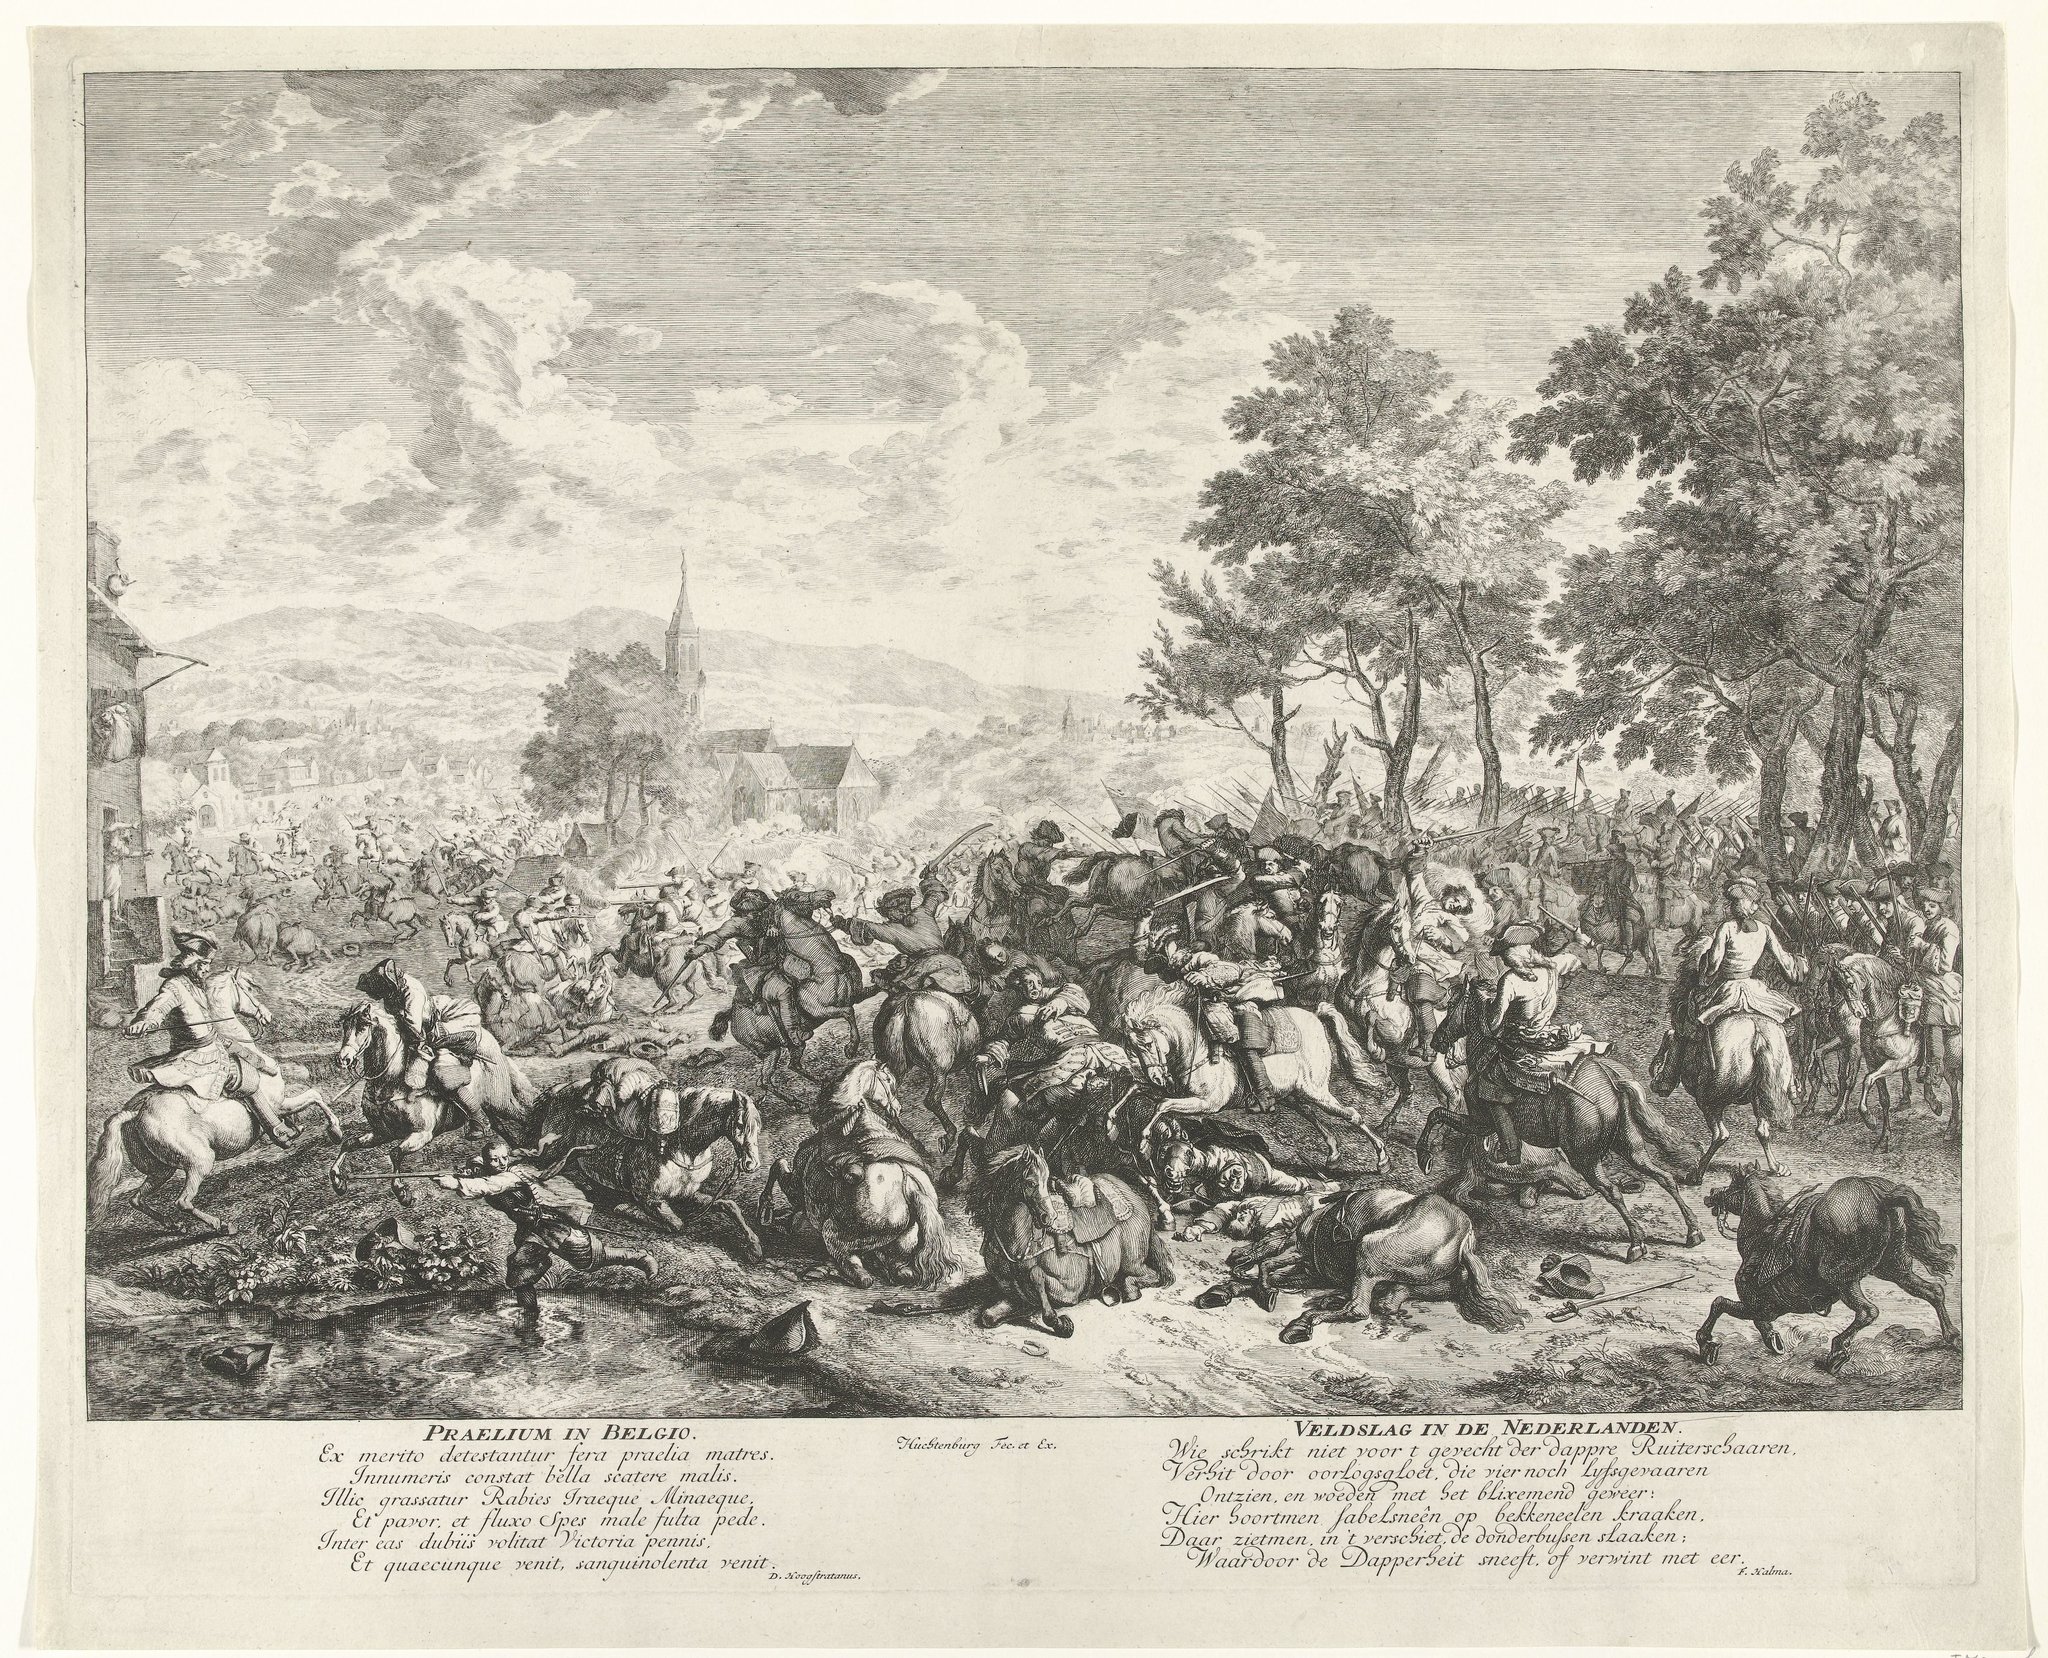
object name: print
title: Praelium in Belgio / Veldslag in de Nederlanden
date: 1701-1703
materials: paper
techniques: etching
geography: northern netherlands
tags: battle (+ land forces)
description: Gezicht op een woest ruitergevecht in de Nederlanden, ten tijde van de Spaanse Successieoorlog, ca. 1702. In het onderschriften verzen in het Latijn en Nederlands.